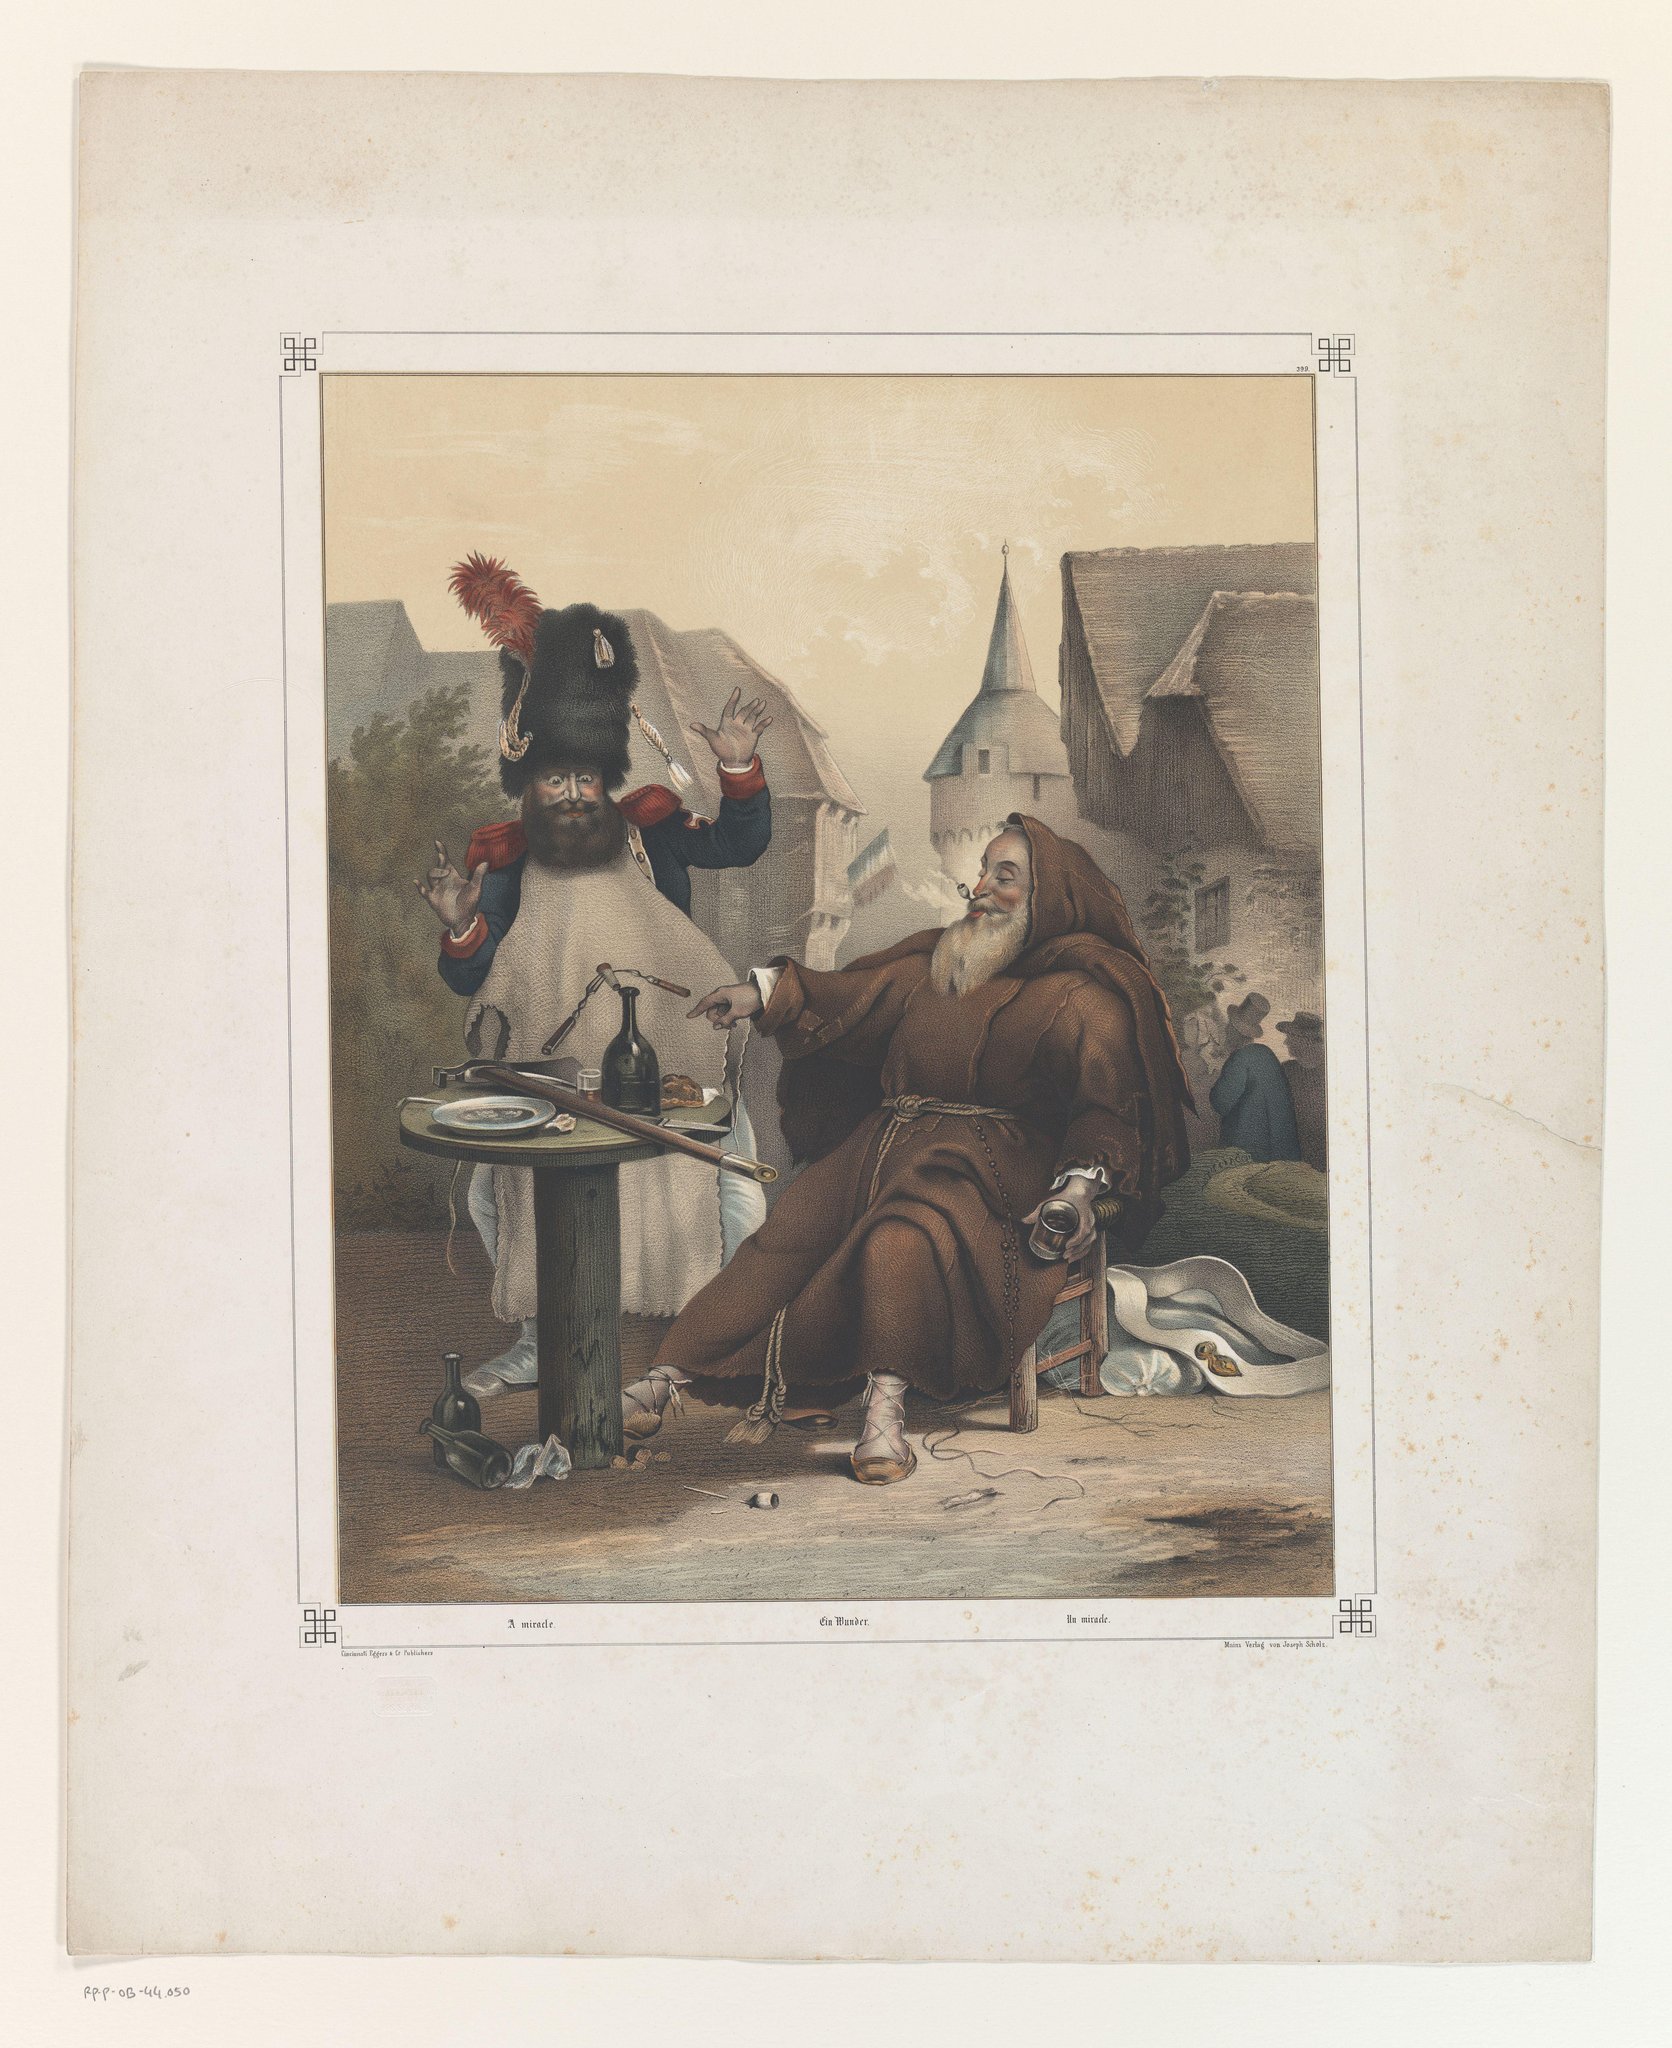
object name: print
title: Monnik en officier bij een tafel met attributen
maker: Anonymous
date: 1825-1875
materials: paper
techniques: hand coloring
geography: germany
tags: ranks (in the army, navy, air force), monk(s), friar(s), furniture and household effects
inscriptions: check stamp: ‘Mainz Druck&Verlag von Jos. Scholz’, collector's mark: Lugt 2228